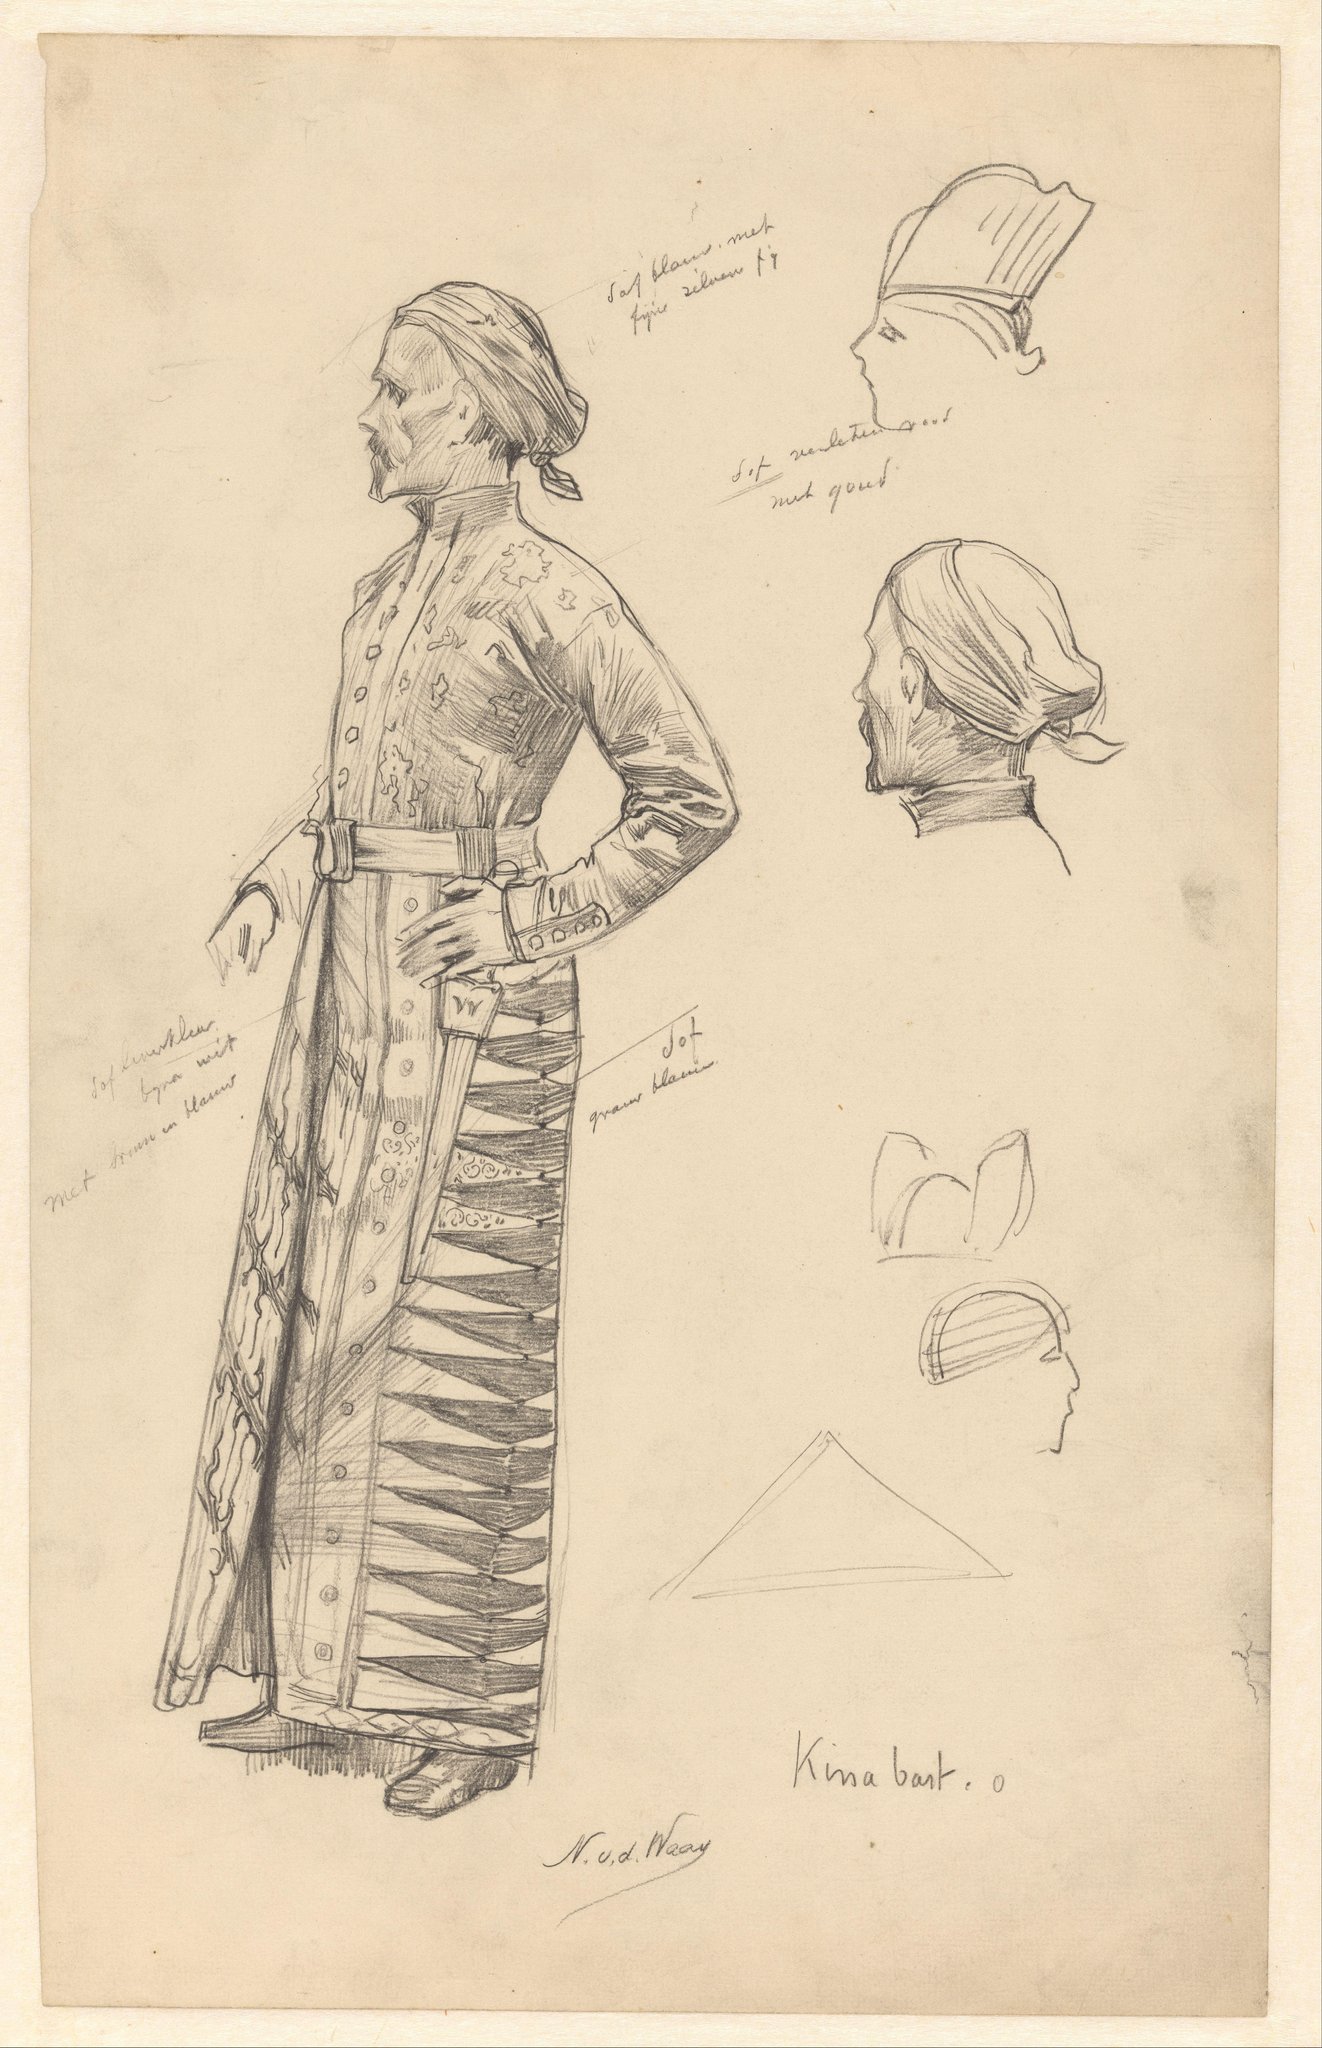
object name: drawing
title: Studieblad met kleding en hoofddeksel van een hoogwaardigheidsbekleder uit Nederlands-Indië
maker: nicolaas van der waay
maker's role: draughtsman, painter, print maker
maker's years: 1855-1936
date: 1865-1936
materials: chalk, paper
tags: asiatic races and peoples (indonesians), fashion, clothing, head-gear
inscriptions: number: ‘973’, annotation: ‘AJ 157/30’, collector's mark: Lugt 2760, collector's mark: Lugt 2228, :